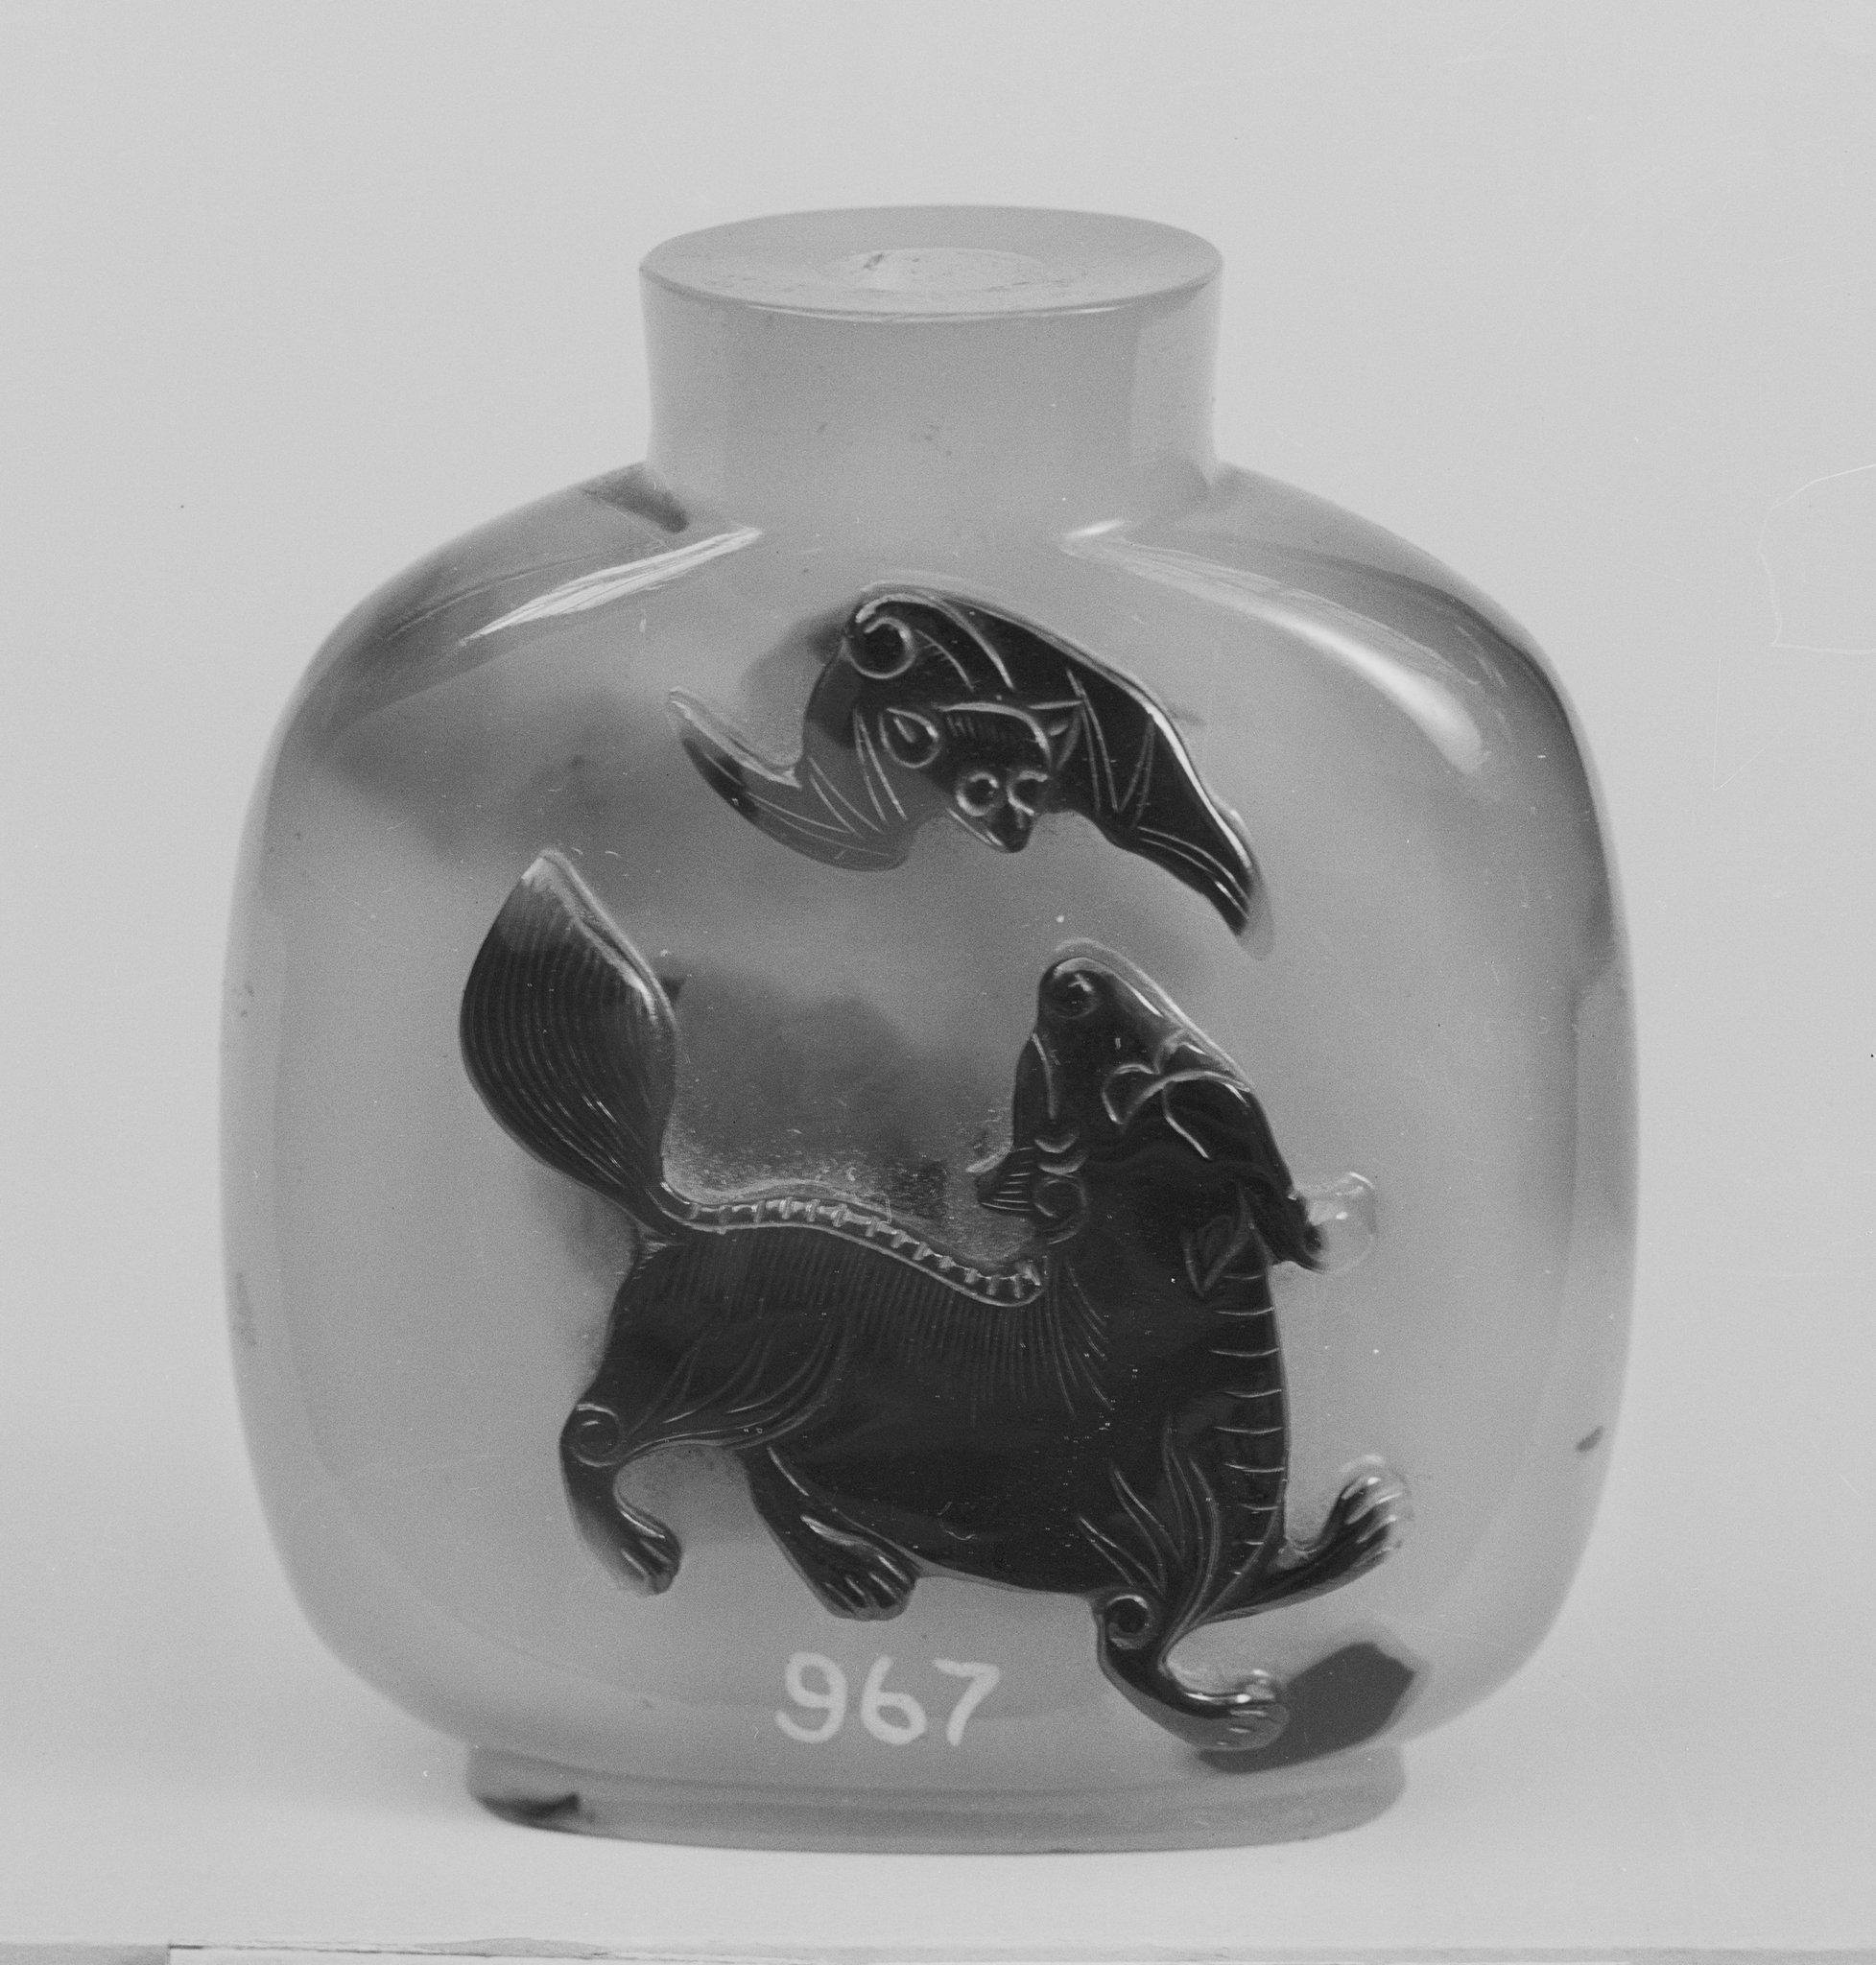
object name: snuff bottle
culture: chinese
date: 1701-1900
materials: stone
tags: bats,dogs